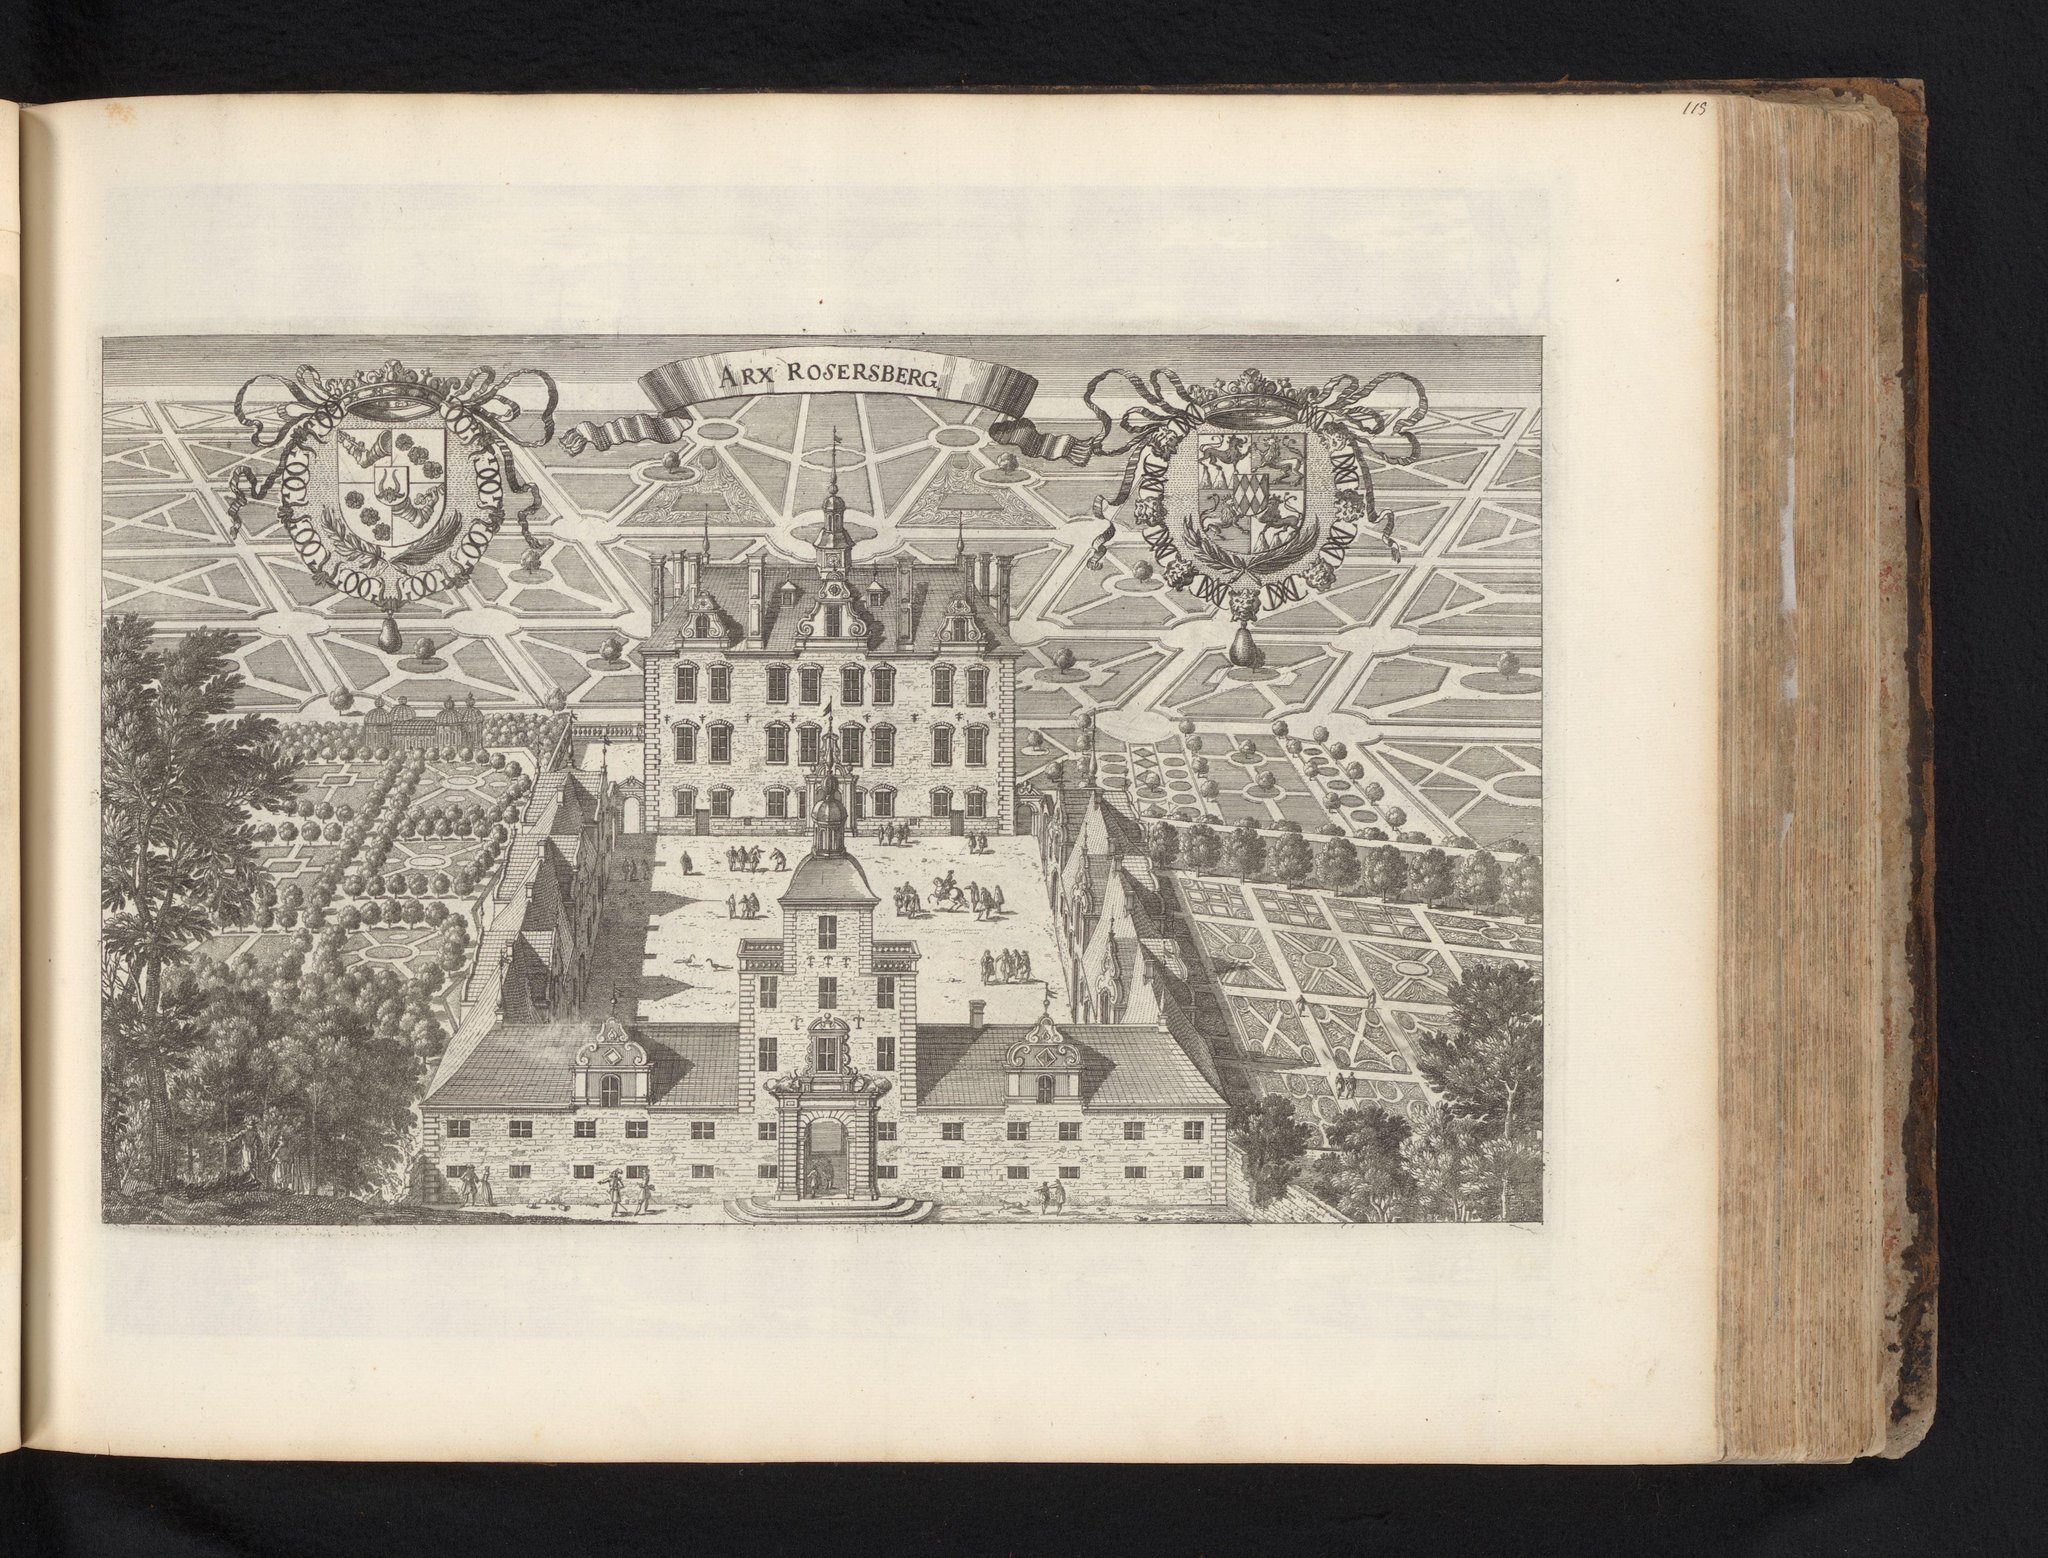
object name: album leaf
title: Gezicht op slot Rosersberg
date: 1670-1674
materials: paper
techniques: etching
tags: housing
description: Kungliga Biblioteket, 'Suecia': http://www.kb.se/samlingarna/Kartor-bilder/Suecia-antiqua/ (geraadpleegd november 2016).